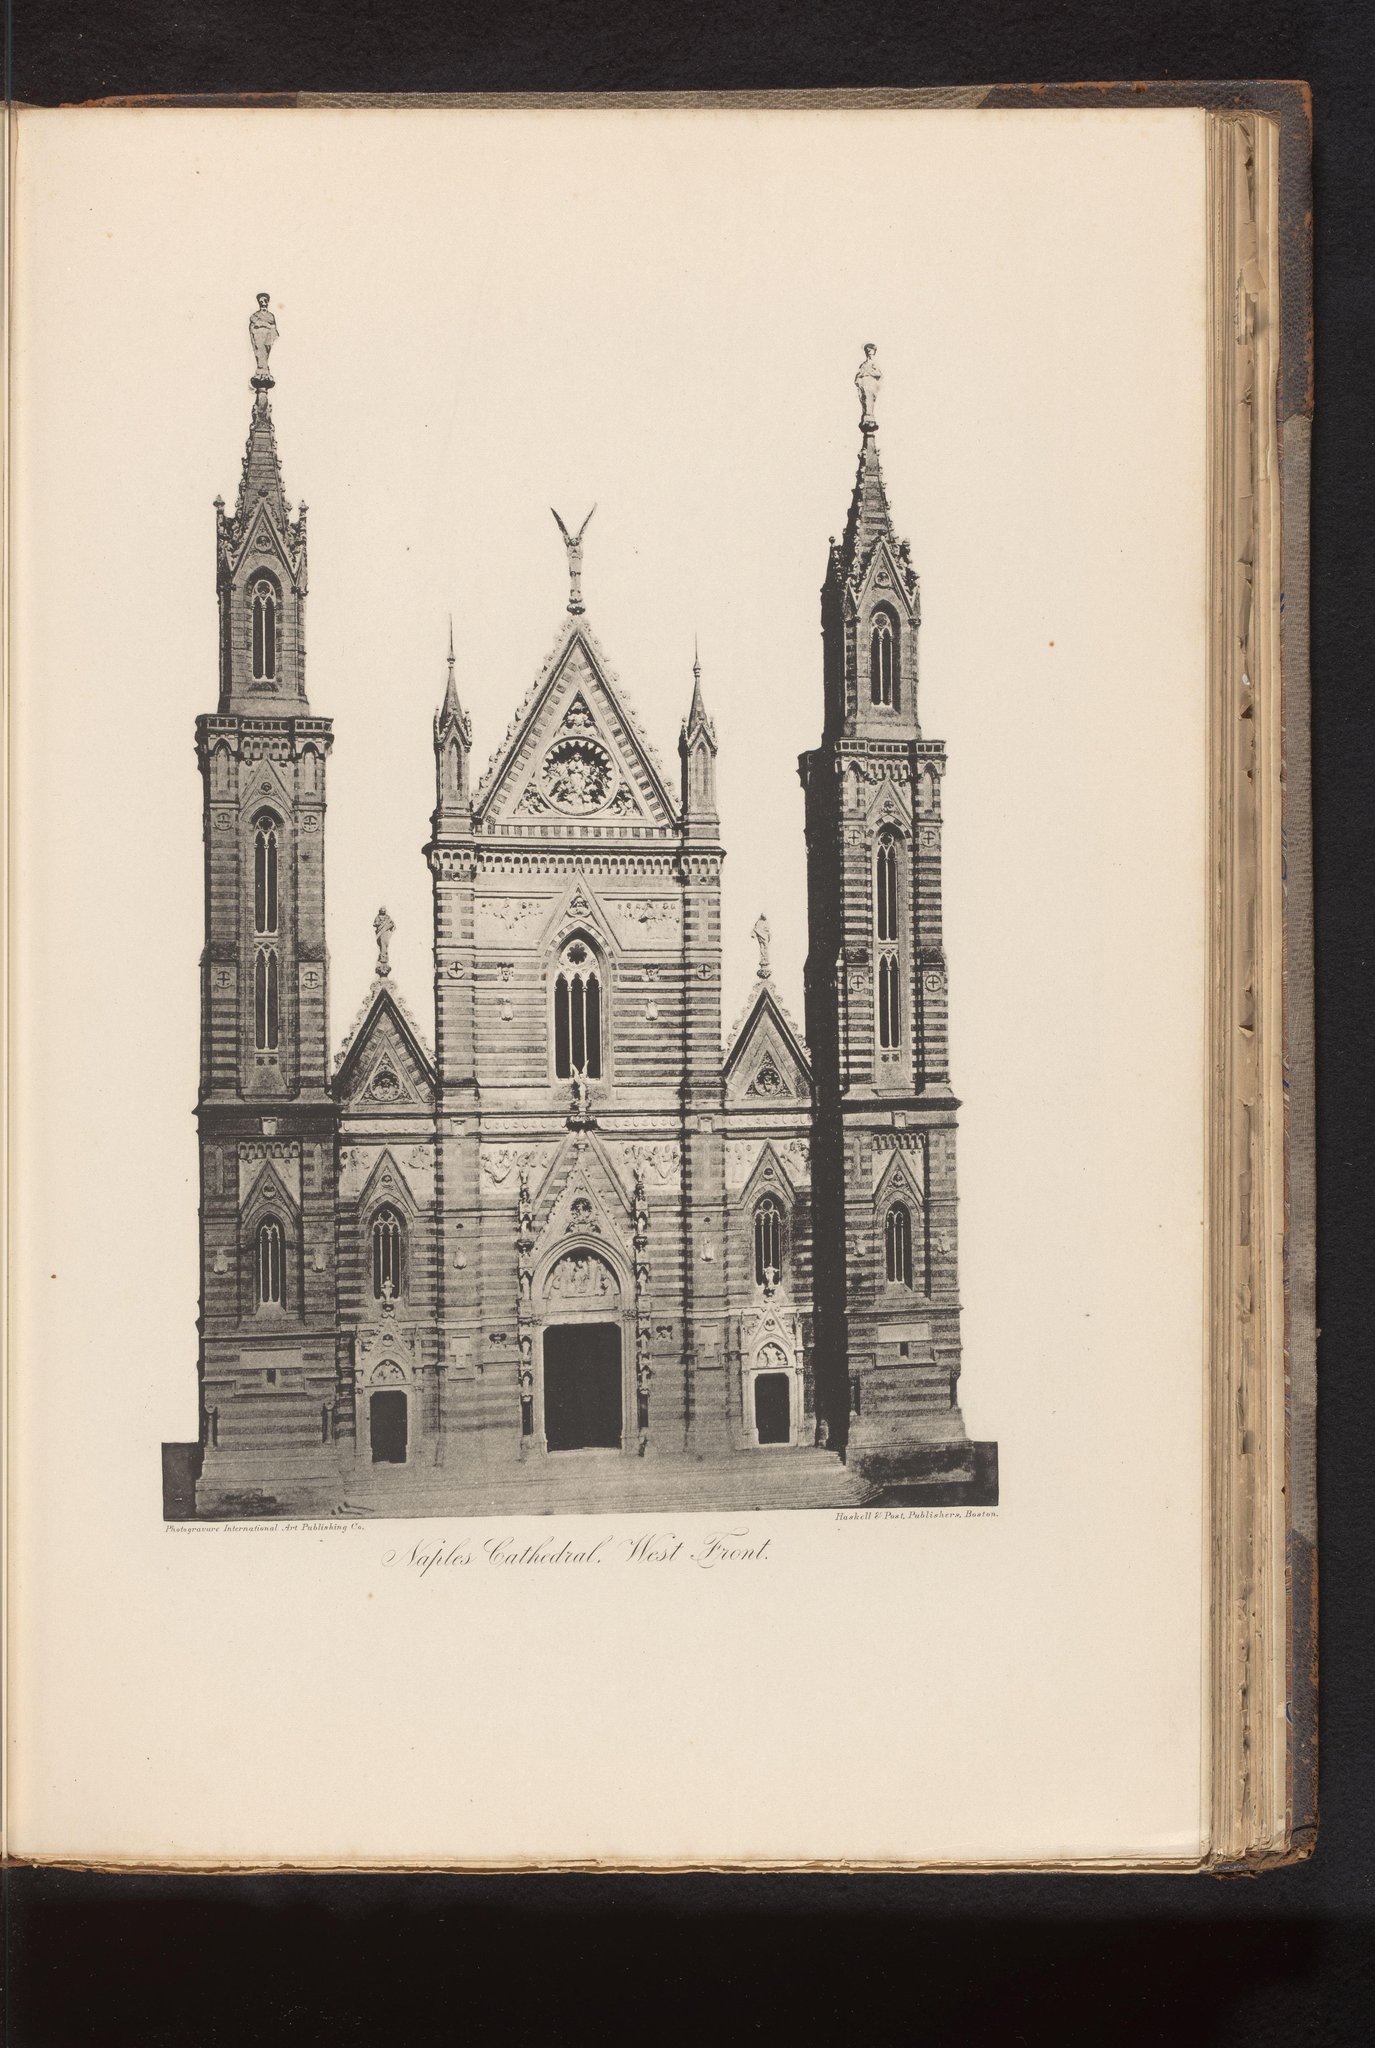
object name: photomechanical print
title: Westzijde van de kathedraal van Napels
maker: Anonymous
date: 1881-1886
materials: paper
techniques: photograph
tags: church (exterior), façade (of house or building)